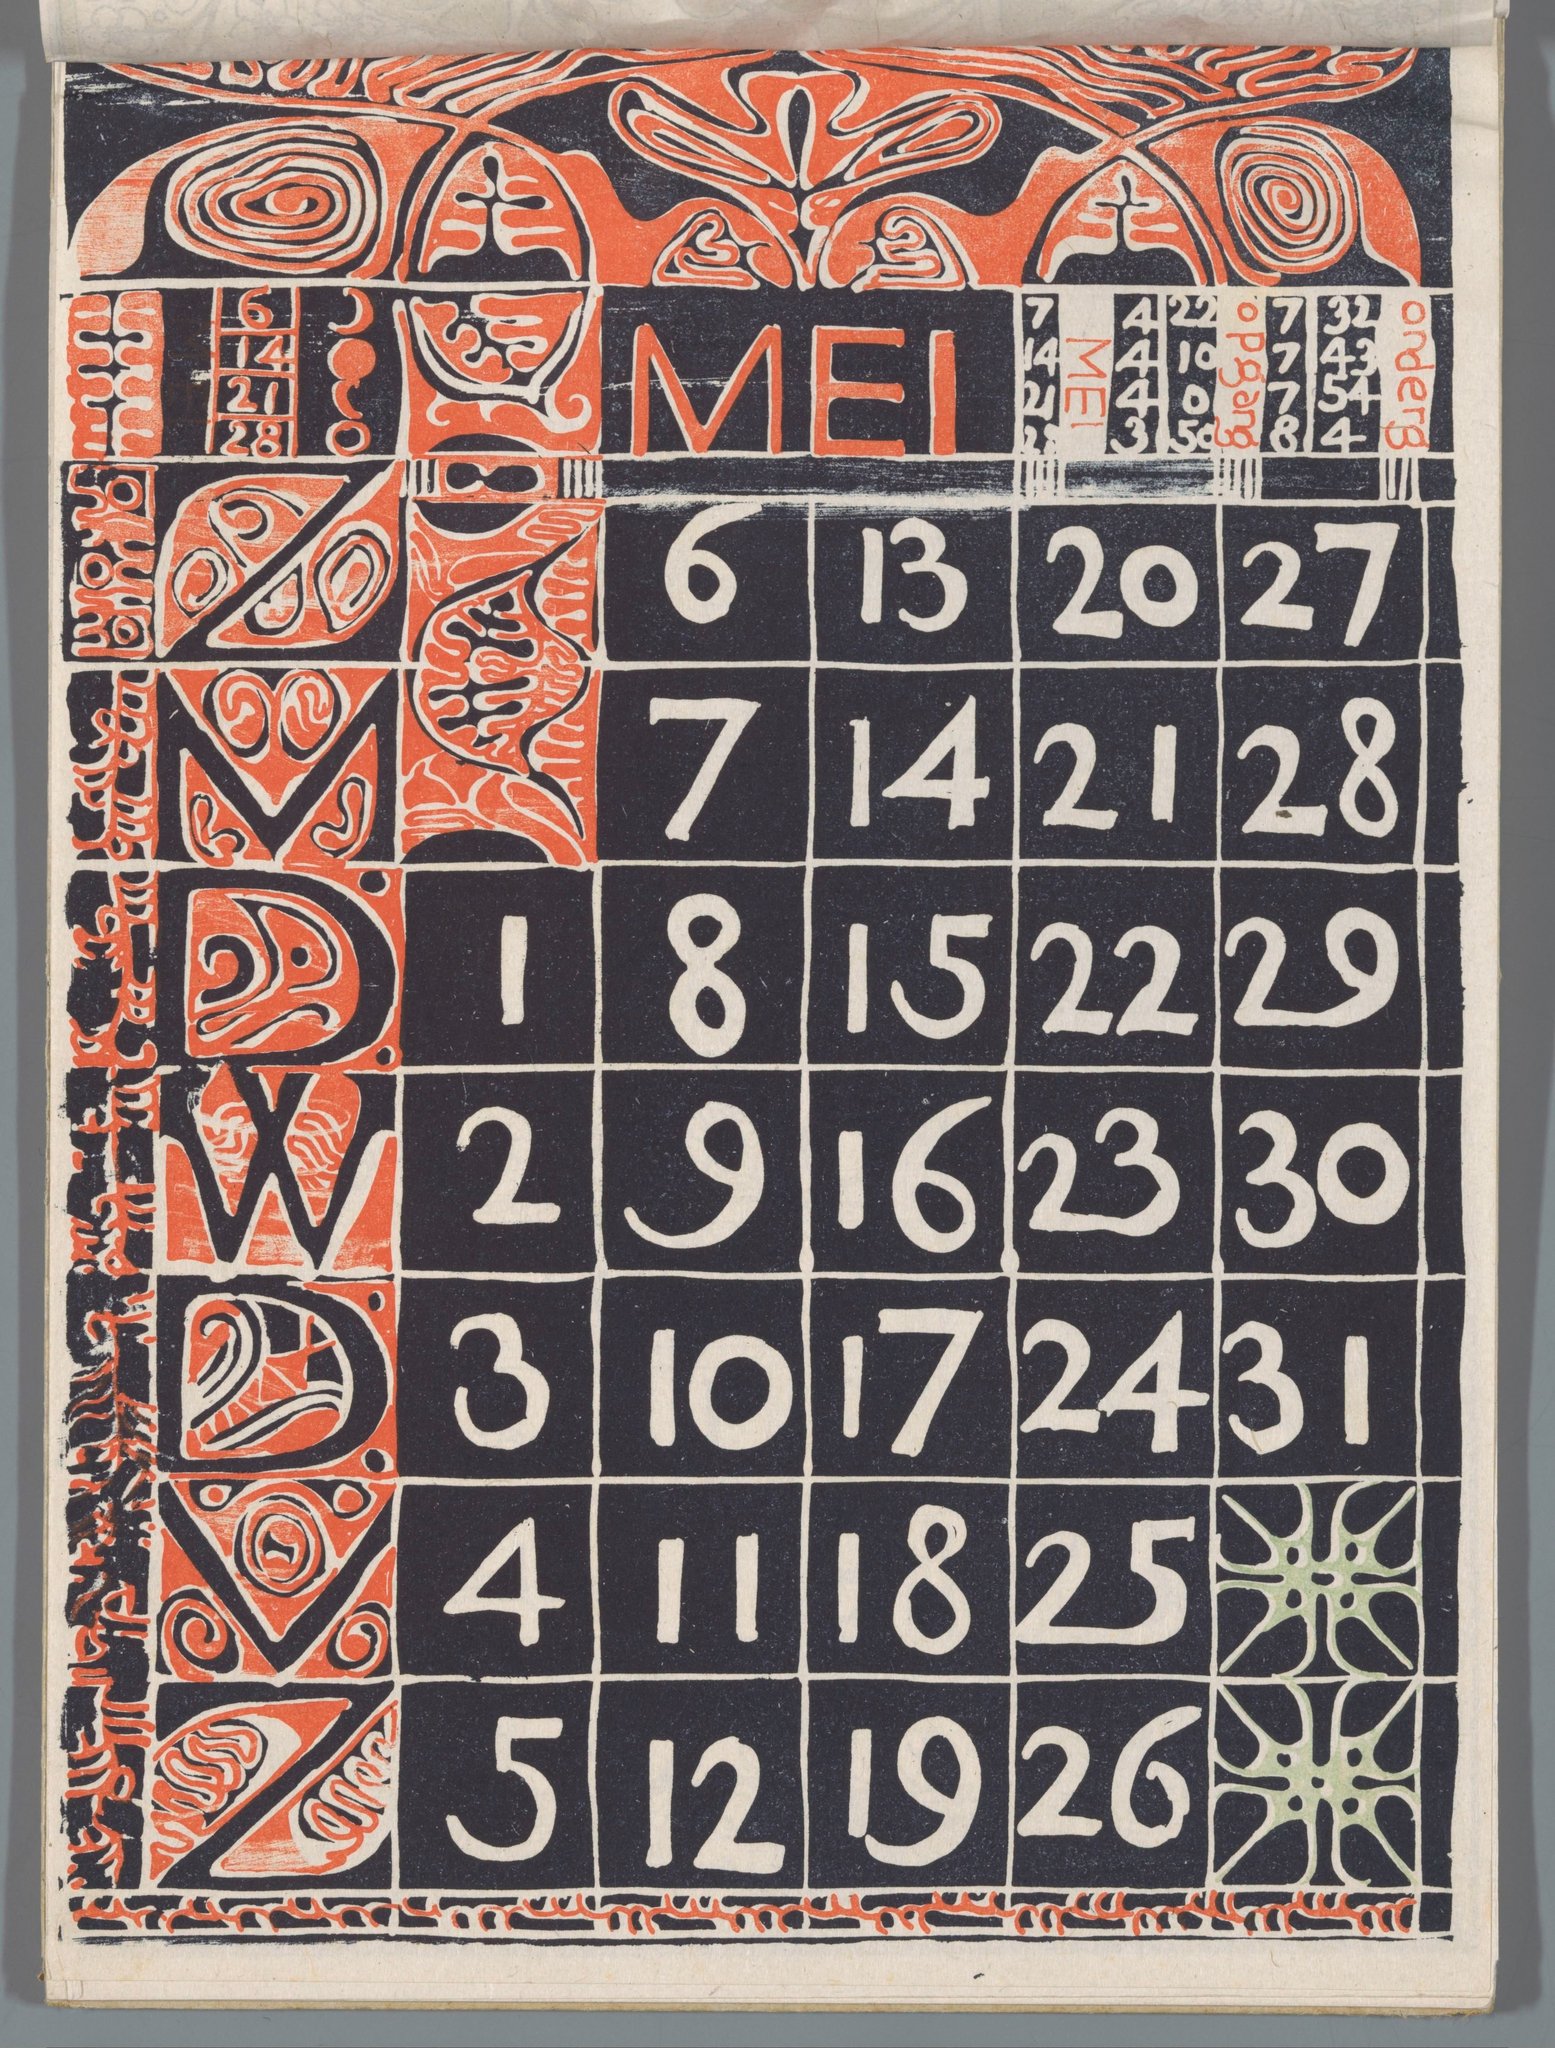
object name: print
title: Kalenderblad mei 1900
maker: carel adolph lion cachet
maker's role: draughtsman, print maker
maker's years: 1864-1945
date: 1900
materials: paper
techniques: lithograph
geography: amsterdam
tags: may ~ other concepts